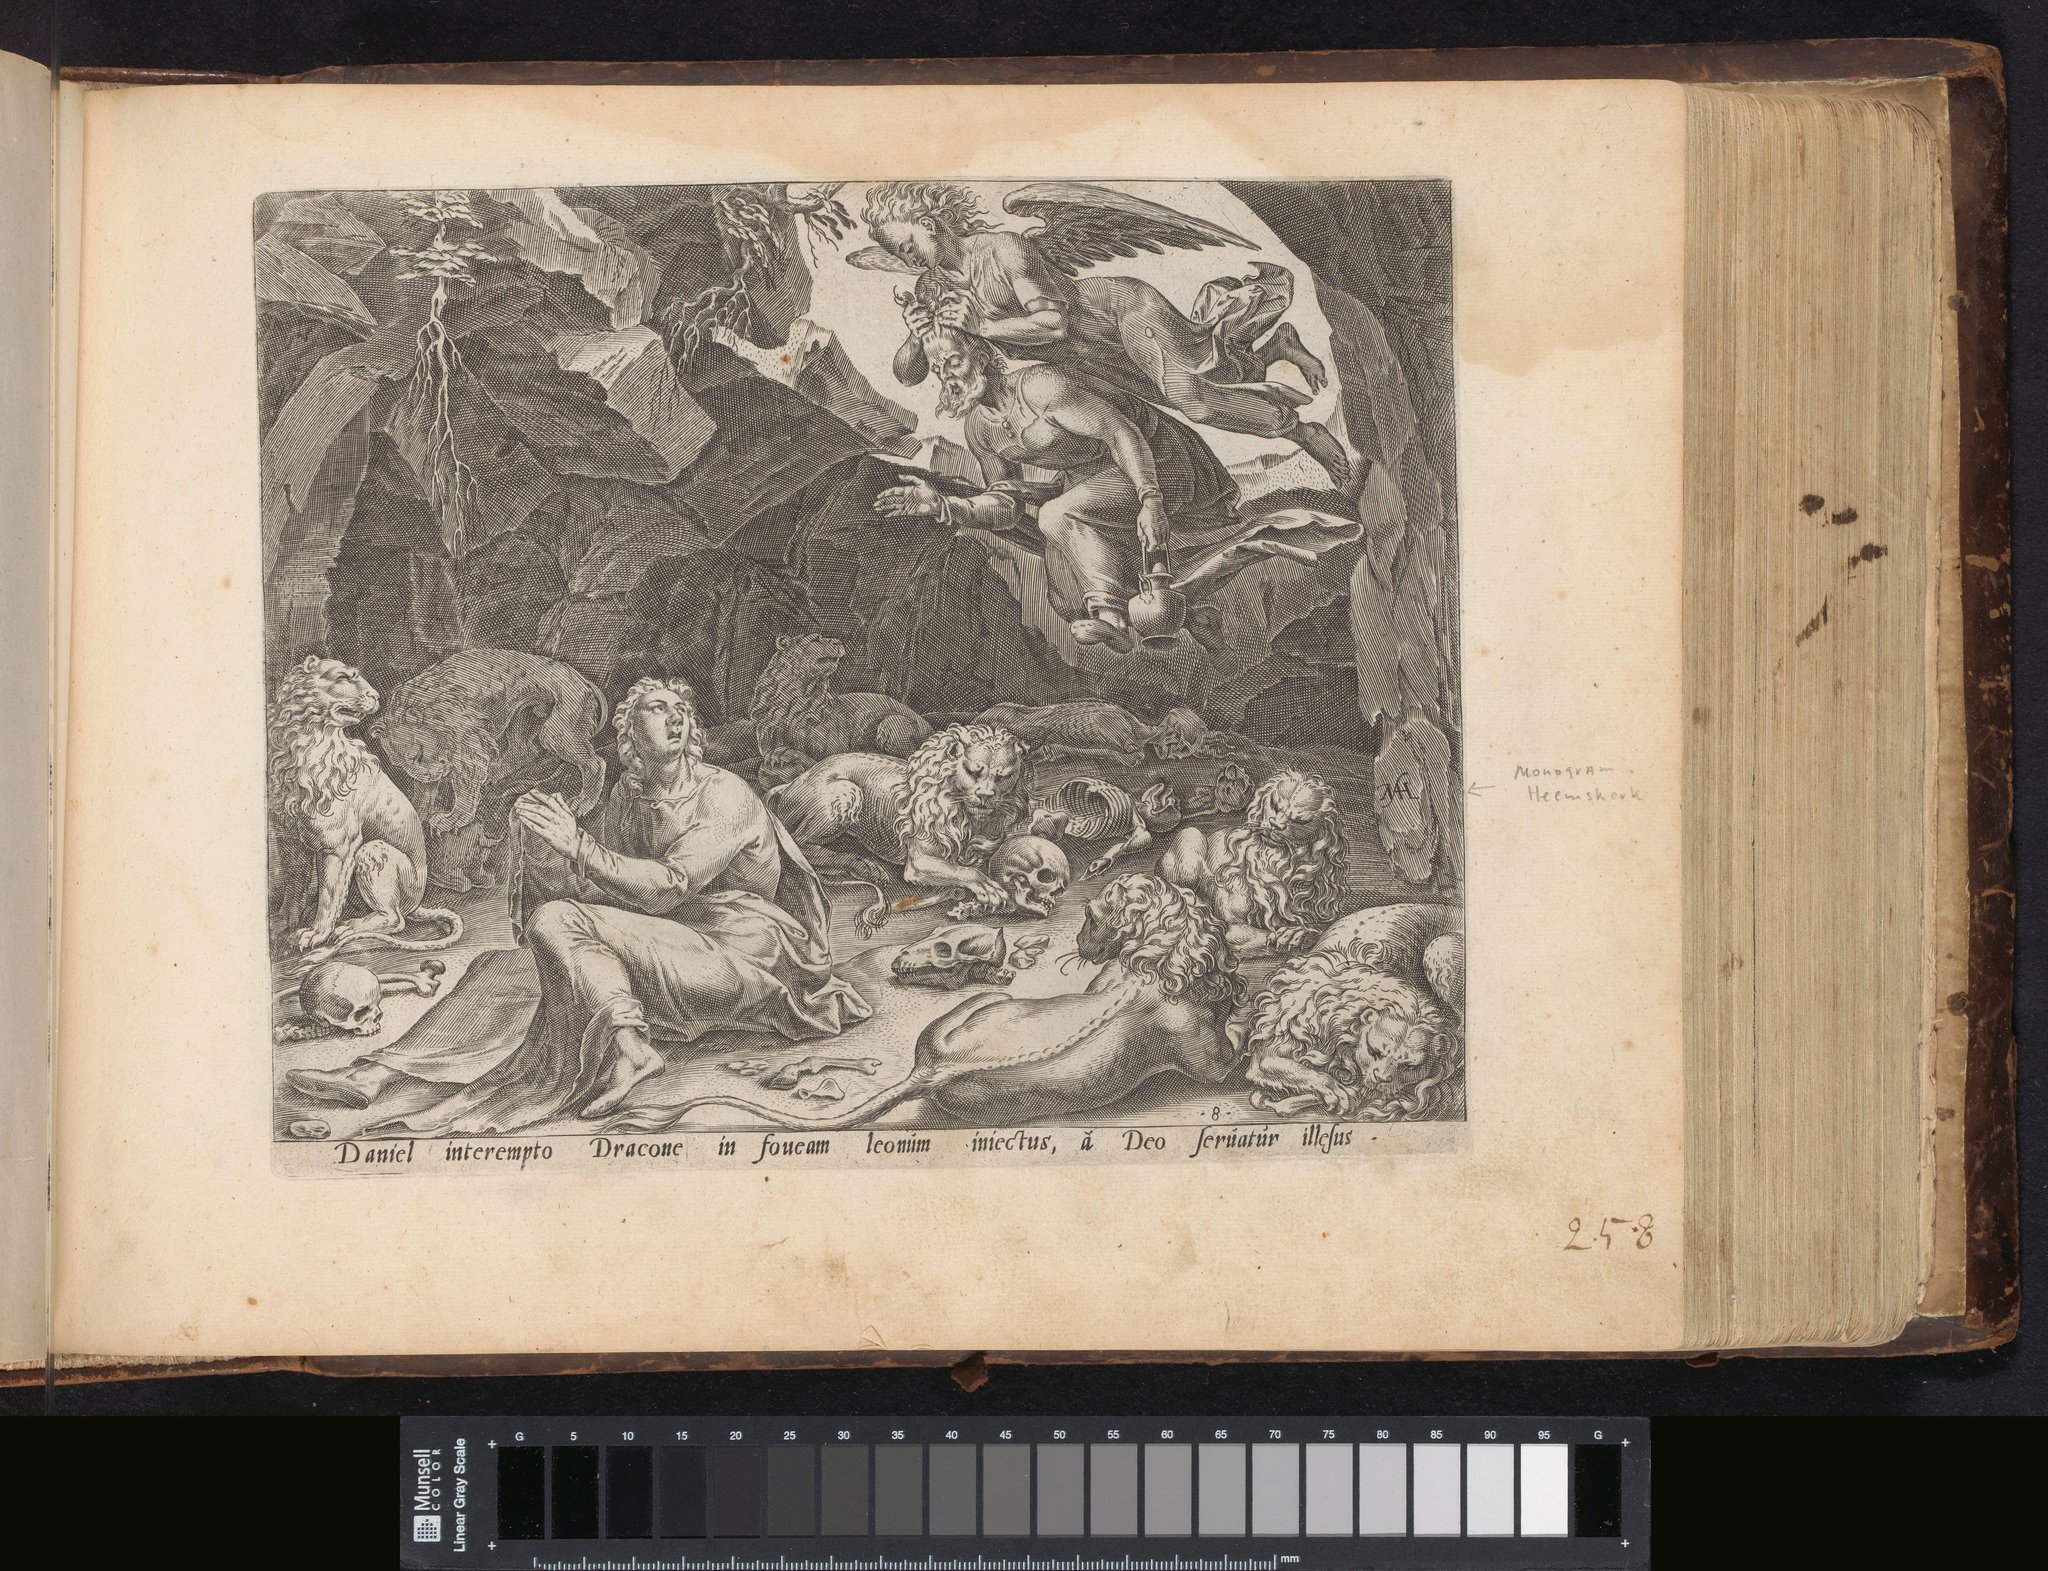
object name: print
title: Geschiedenis van Daniël, Bel en de draak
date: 1565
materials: paper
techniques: engraving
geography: alkmaar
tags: the prophet habakkuk, carried by his hair by an angel, brings food to daniel who sits unharmed between the lions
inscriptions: number: ‘258’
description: Daniël zit gevangen in de leeuwenkuil met zeven leeuwen. Een engel brengt de profeet Habakuk naar de leeuwenkuil. Habakuk heeft op verzoek van God eten voor Daniël meegenomen. Onder de voorstelling een verklarende tekst in het Latijn. Prent maakt deel uit van een album.